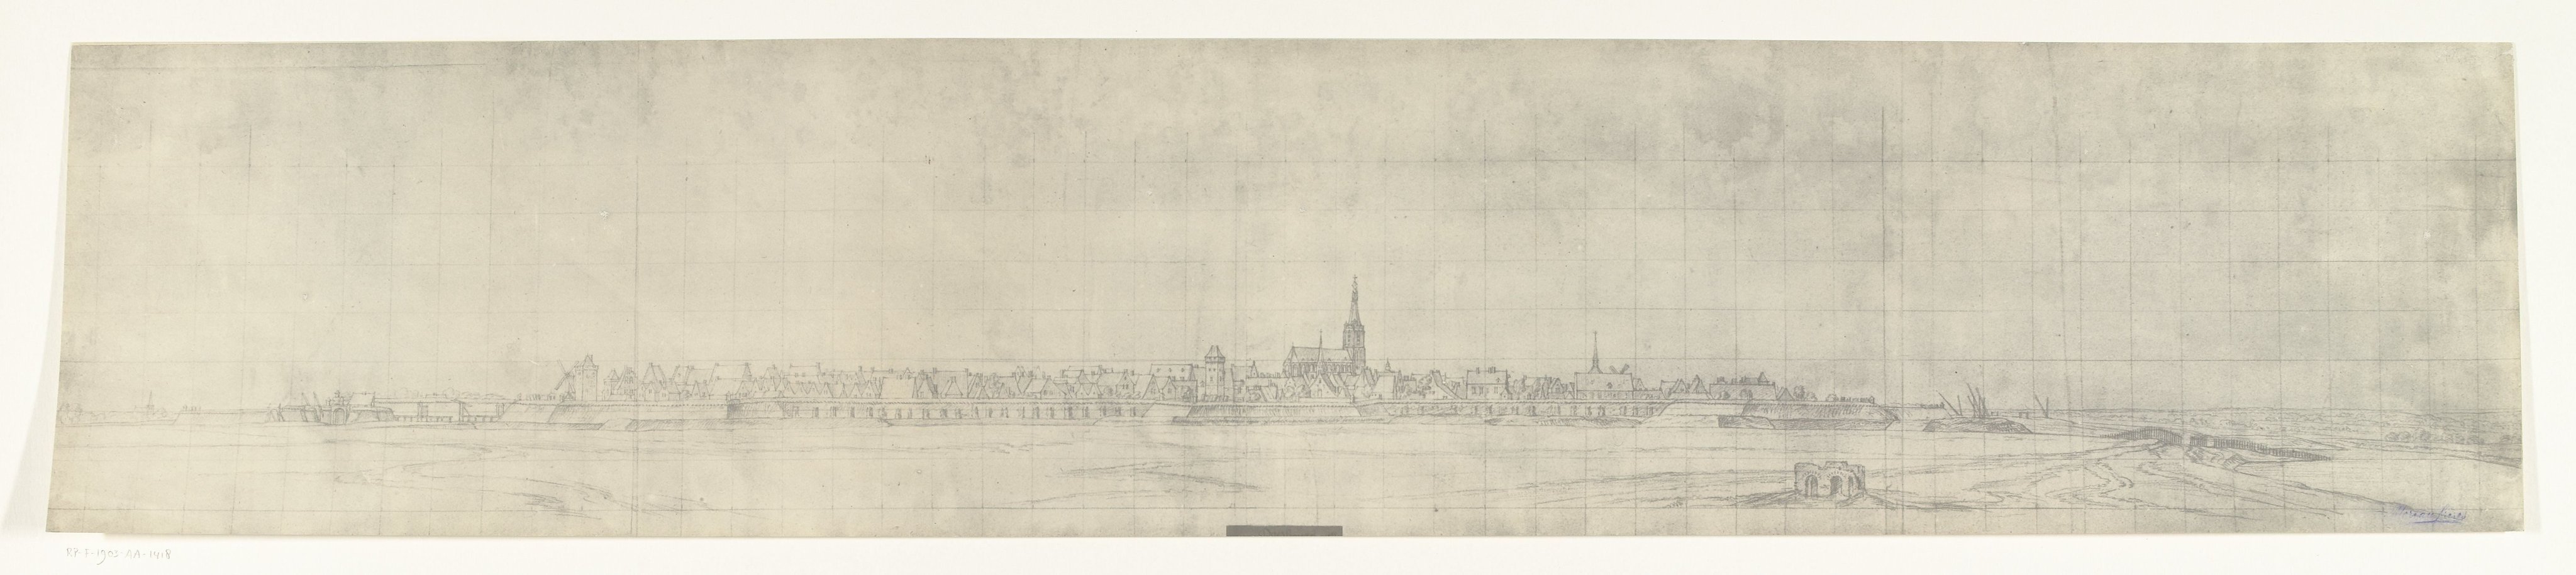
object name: photograph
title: Gezicht op Doesburg, 1672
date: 1900-1903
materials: paper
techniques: gelatin silver print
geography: france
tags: lodewijk xiv (koning van frankrijk), city-view, and landscape with man-made constructions, rampjaar (disaster year)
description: Niet in Frederik Muller; door het RPK toegevoegd nummer. Onderdeel van een groep van ca. 50 foto's van tekeningen van de Franse inval in de Nederlanden in 1672 door Adam Frans van der Meulen, bewaard in de Manufacture Nationale des Gobelins te Parijs.